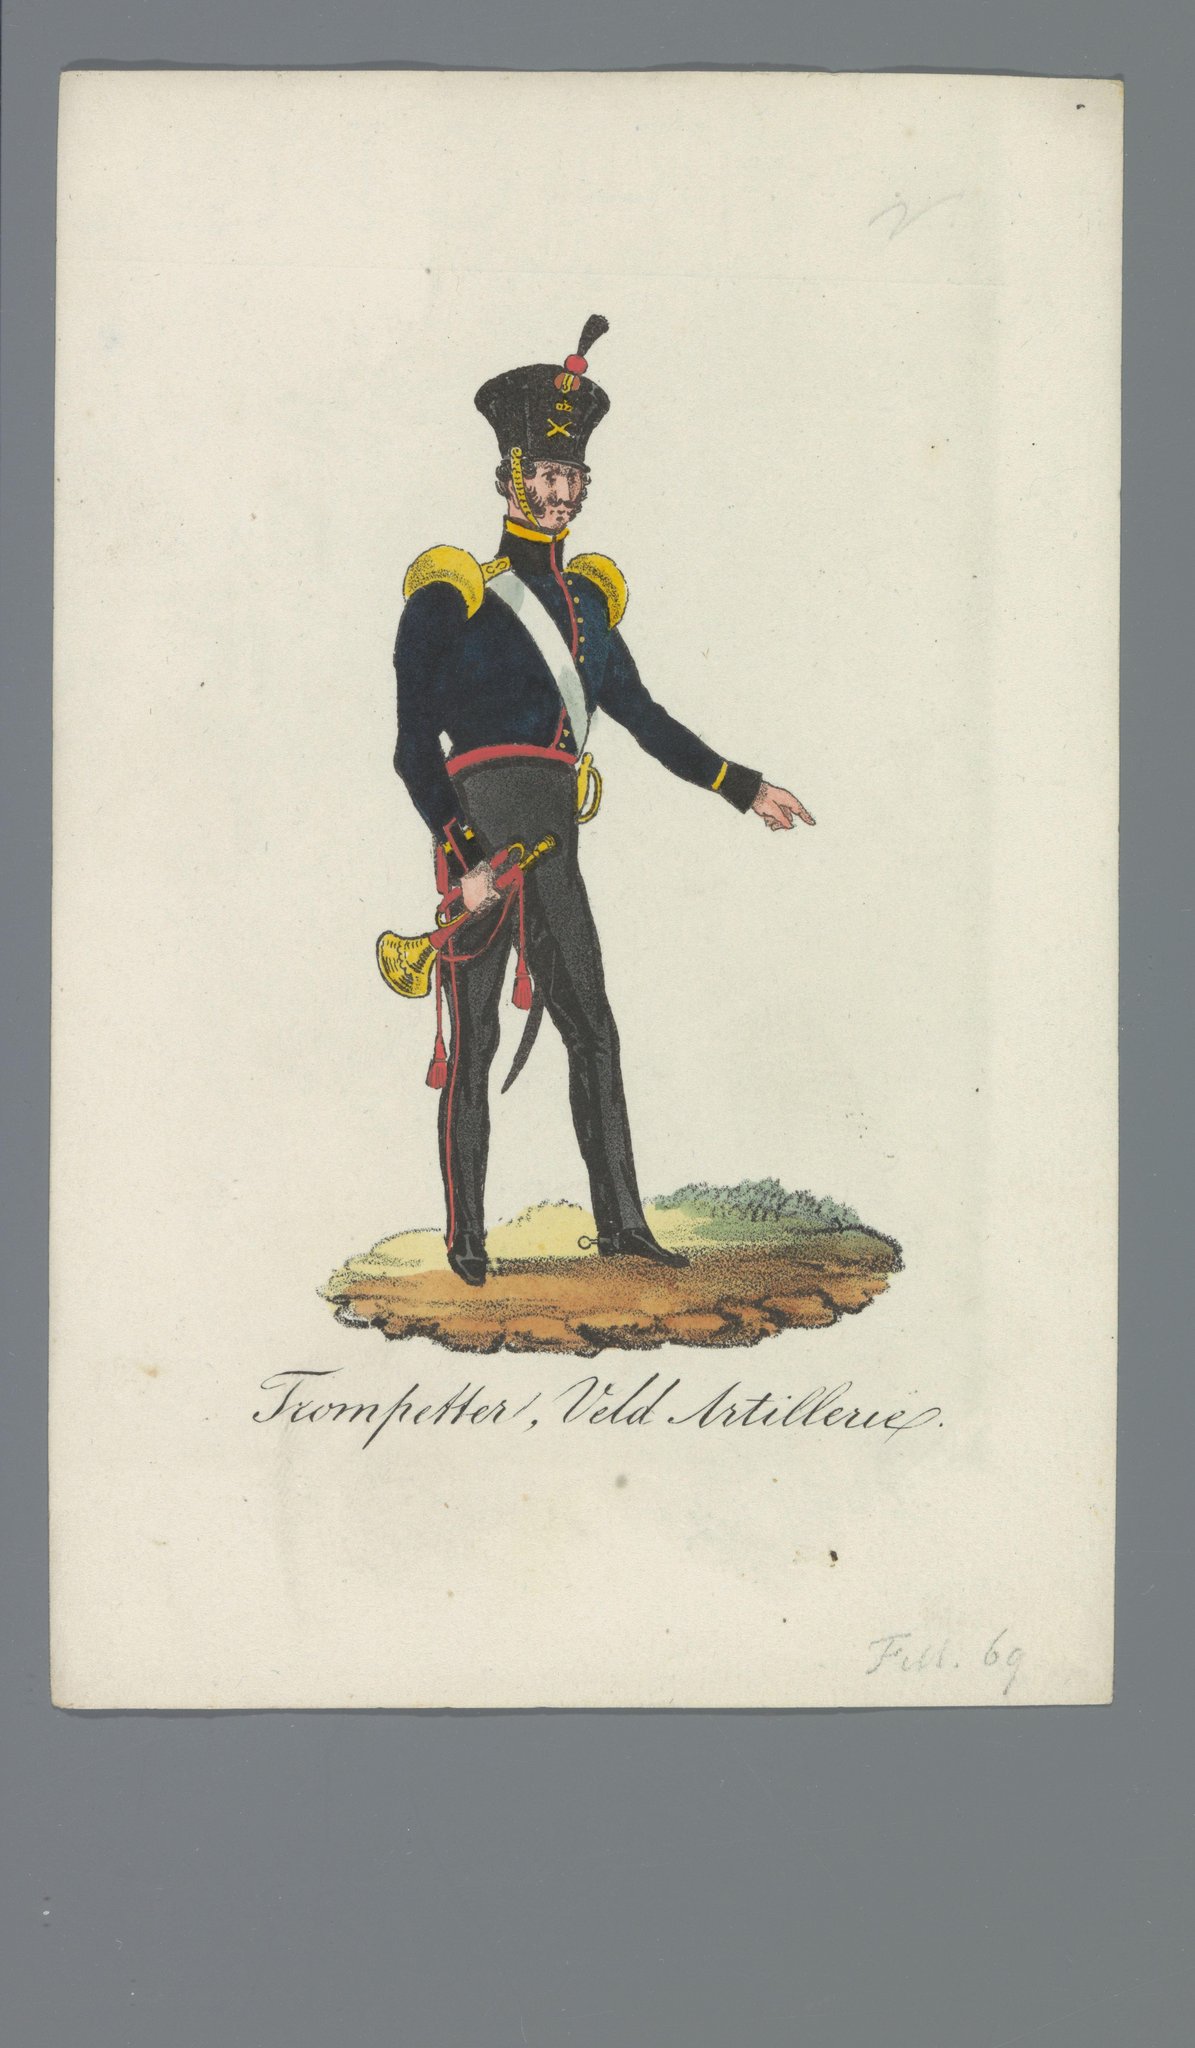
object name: costume print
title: Trompetter, Veld Artillerie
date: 1835-1850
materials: paper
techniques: hand coloring, lithograph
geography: netherlands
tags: (military) uniforms, clothes, costume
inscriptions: collector's mark: Lugt 2228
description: Staande trompetter van de veldartillerie. Onderdeel van een serie van 157 losse bladen met Nederlandse militaire uniformen in de jaren 1830-1832.